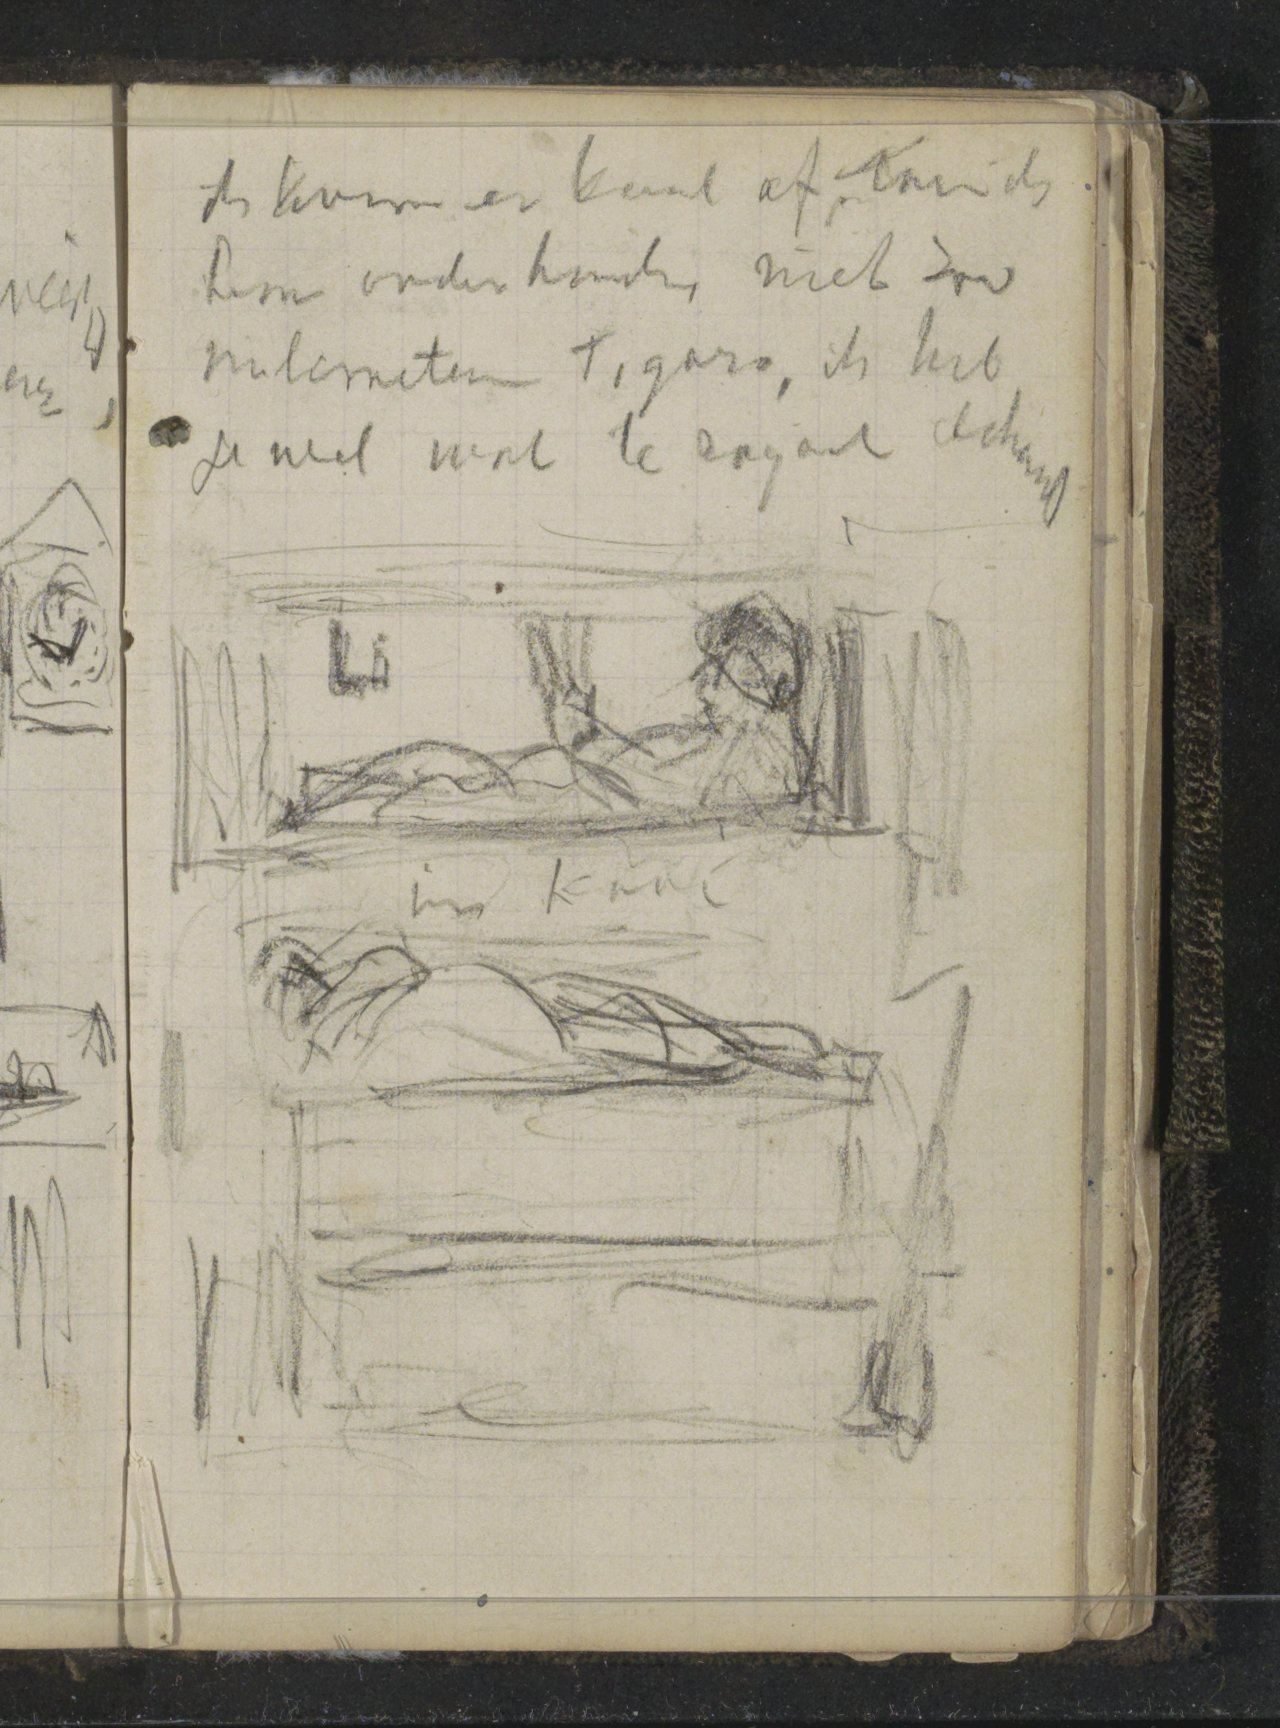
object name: sketchbook leaf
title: Bemanningsleden in hun kooi op de Willem Barentsz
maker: louis apol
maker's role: draughtsman, painter, print maker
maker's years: 1850-1936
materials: chalk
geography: novaya zemlya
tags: crew ~ ship, parts of ship's interior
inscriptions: annotation: ‘de kooien [...]’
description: Blad 81 recto uit een schetsboek met 110 bladen betekend tijdens de expeditie naar Nova Zembla in 1880.